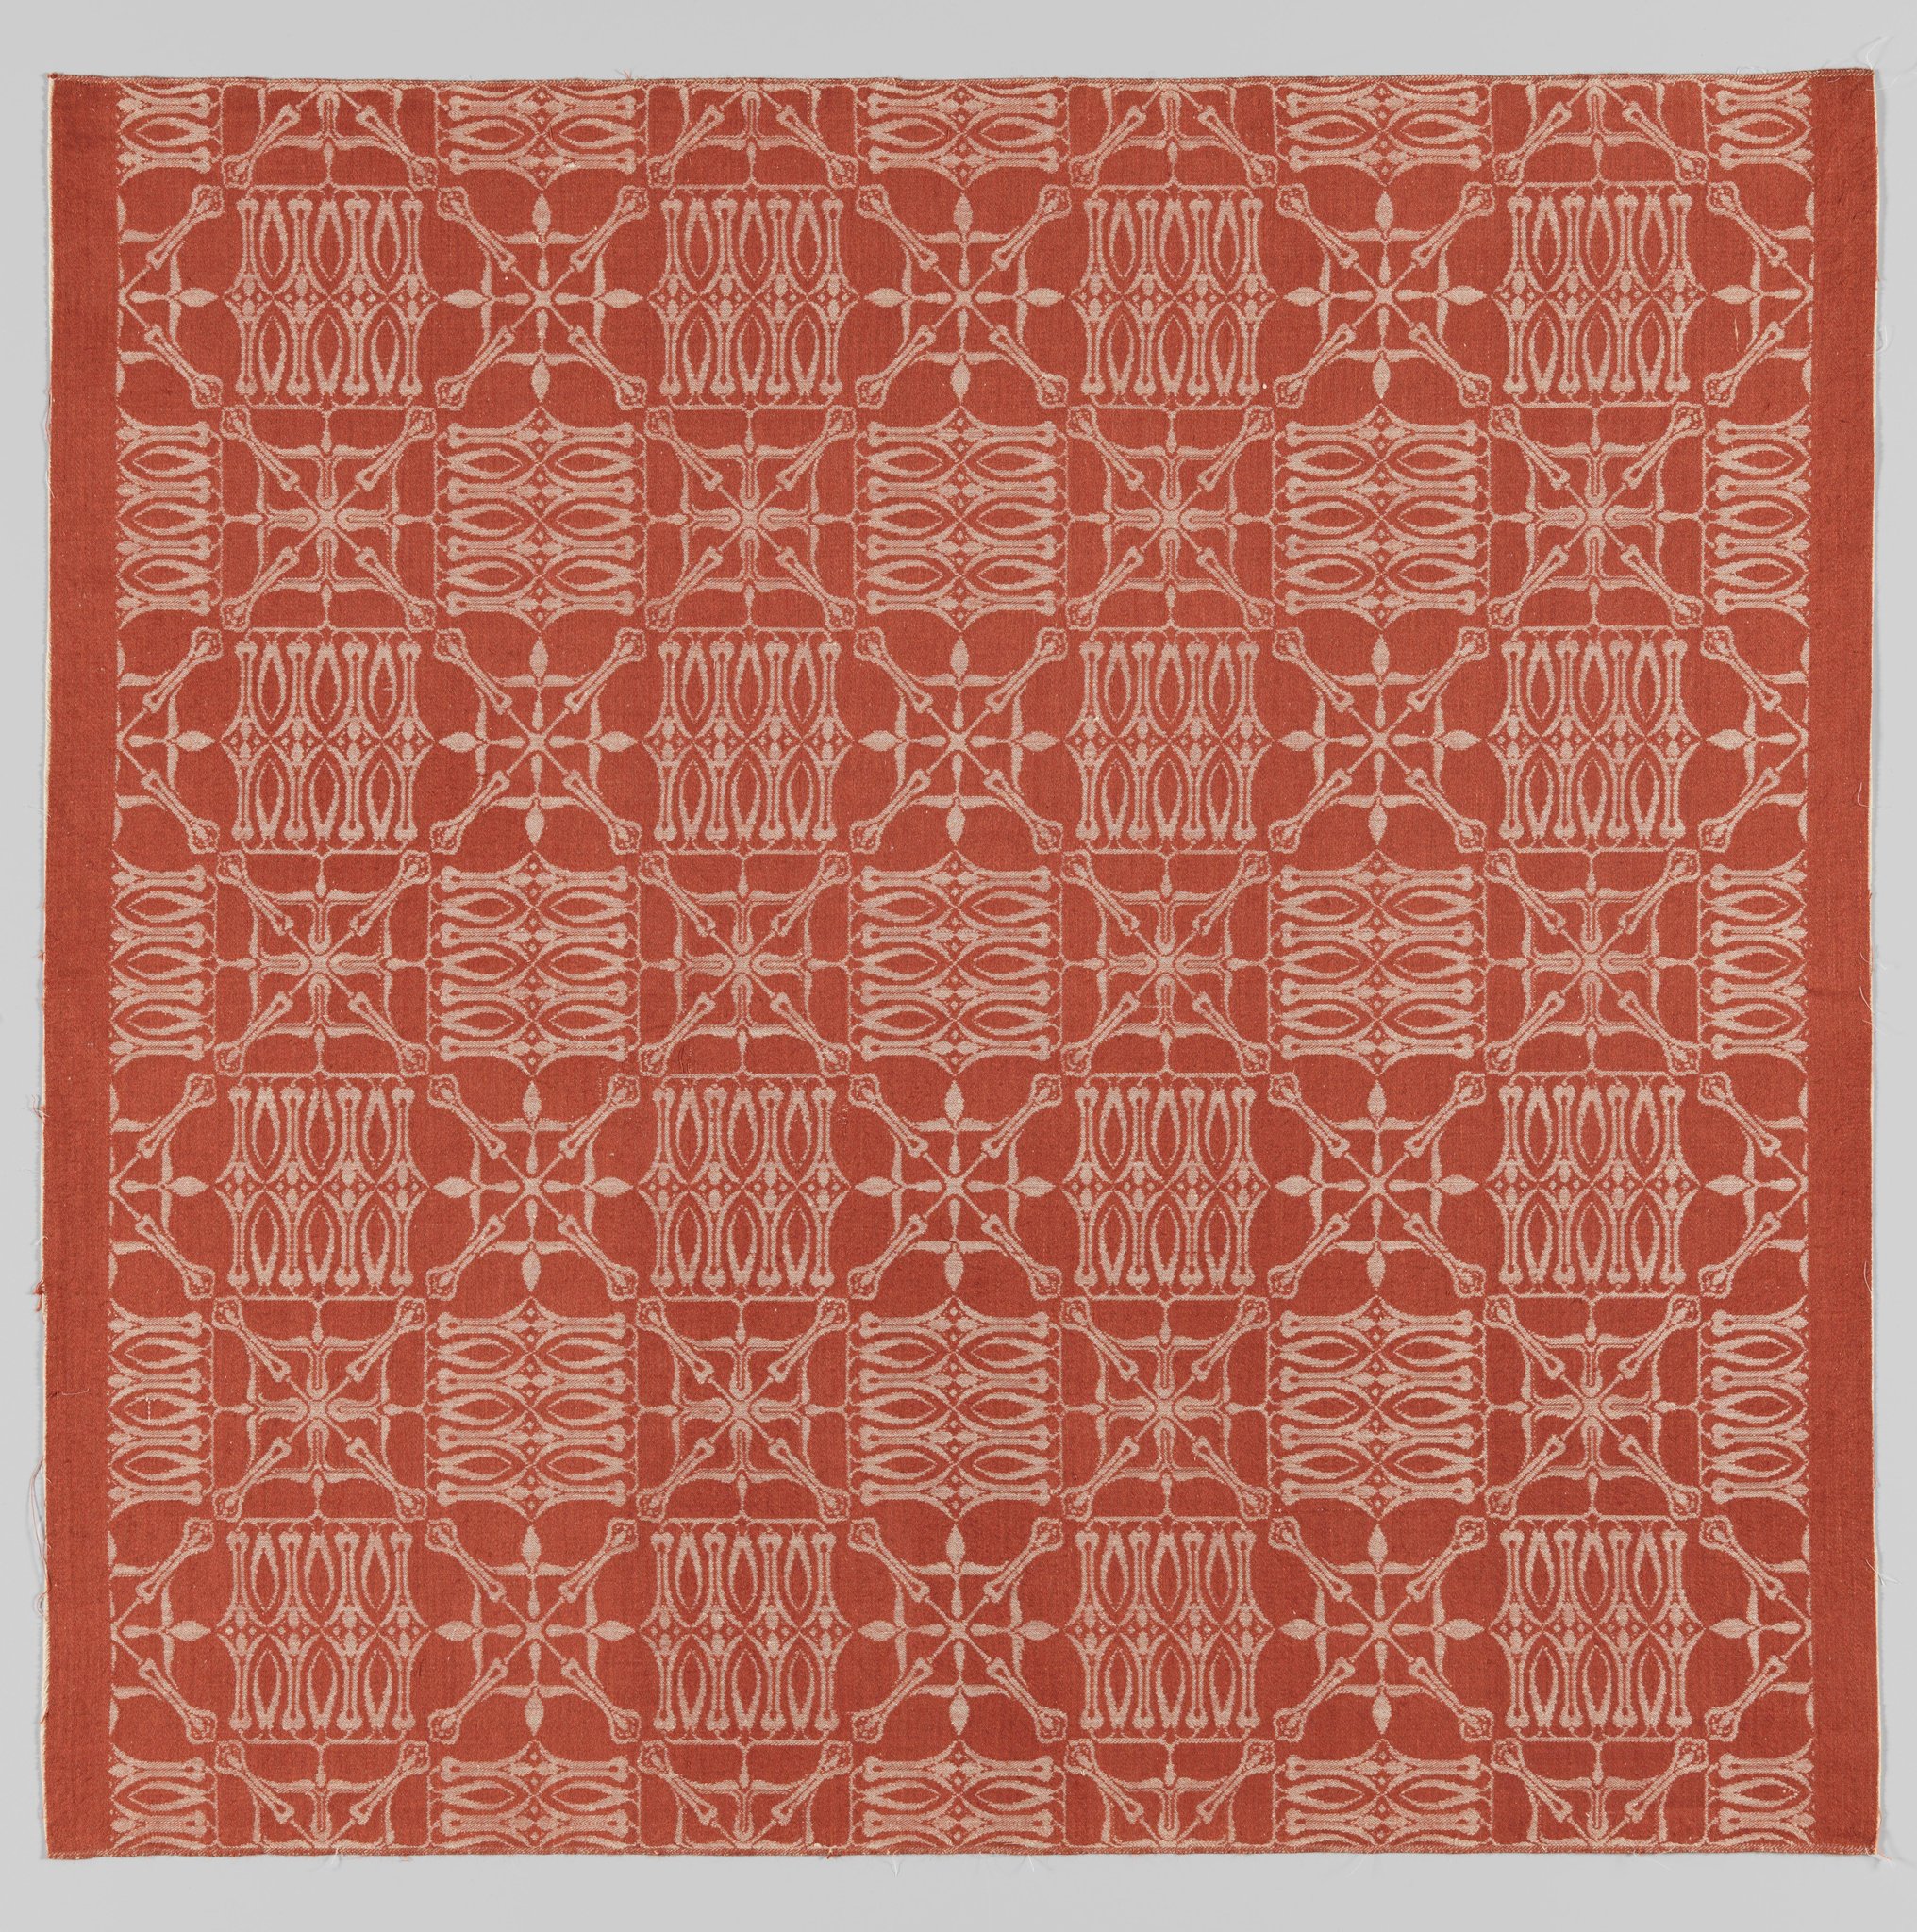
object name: upholstery fabric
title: Staal bespanningsstof van linnendamast met ruit- en blokpatroon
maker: chris lebeau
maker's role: draughtsman, print maker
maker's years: 1878-1945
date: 1911-1915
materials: linen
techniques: damask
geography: eindhoven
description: Staal bespanningsstof van linnendamast met gestileerde ruit- en blokpatroon in naturel op een rode grond.